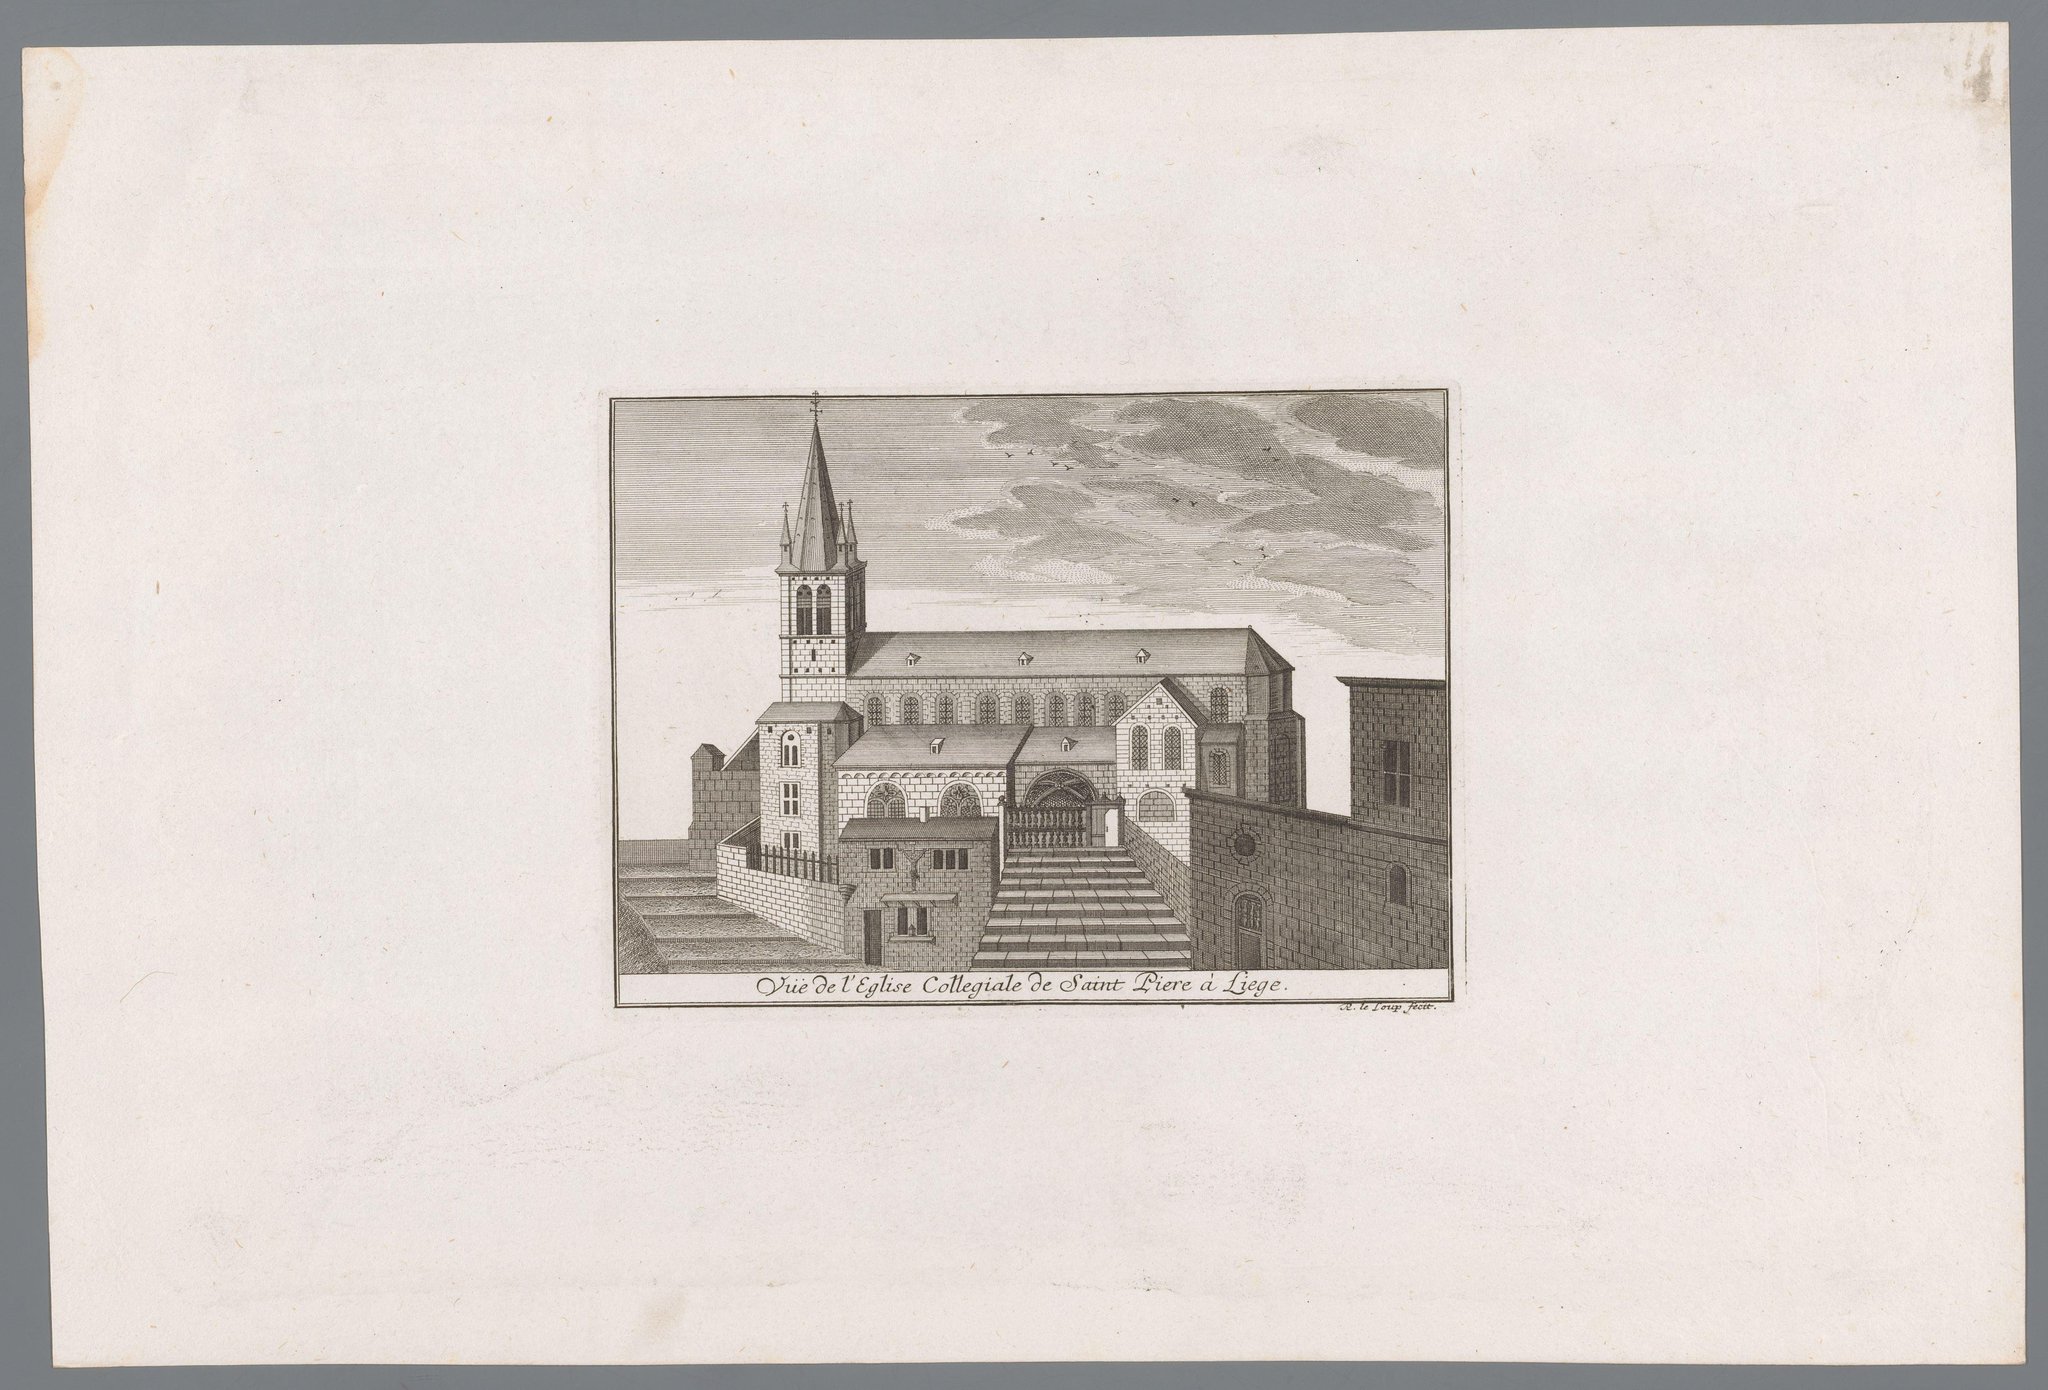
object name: book illustration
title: Gezicht op de Sint-Pieterskerk in Luik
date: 1738-1744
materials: paper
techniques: engraving, etching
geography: liège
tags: church (exterior), liège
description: Prent uit: Johanne de Saumery, Alexandre de et al. Les délices du païs de Liège, ou description géographique, topographique et chorographique des monumes sacrés et profanes (...). 5 dln. Luik: Everard Kints, 1738-1744, dl. 1, p. 119.